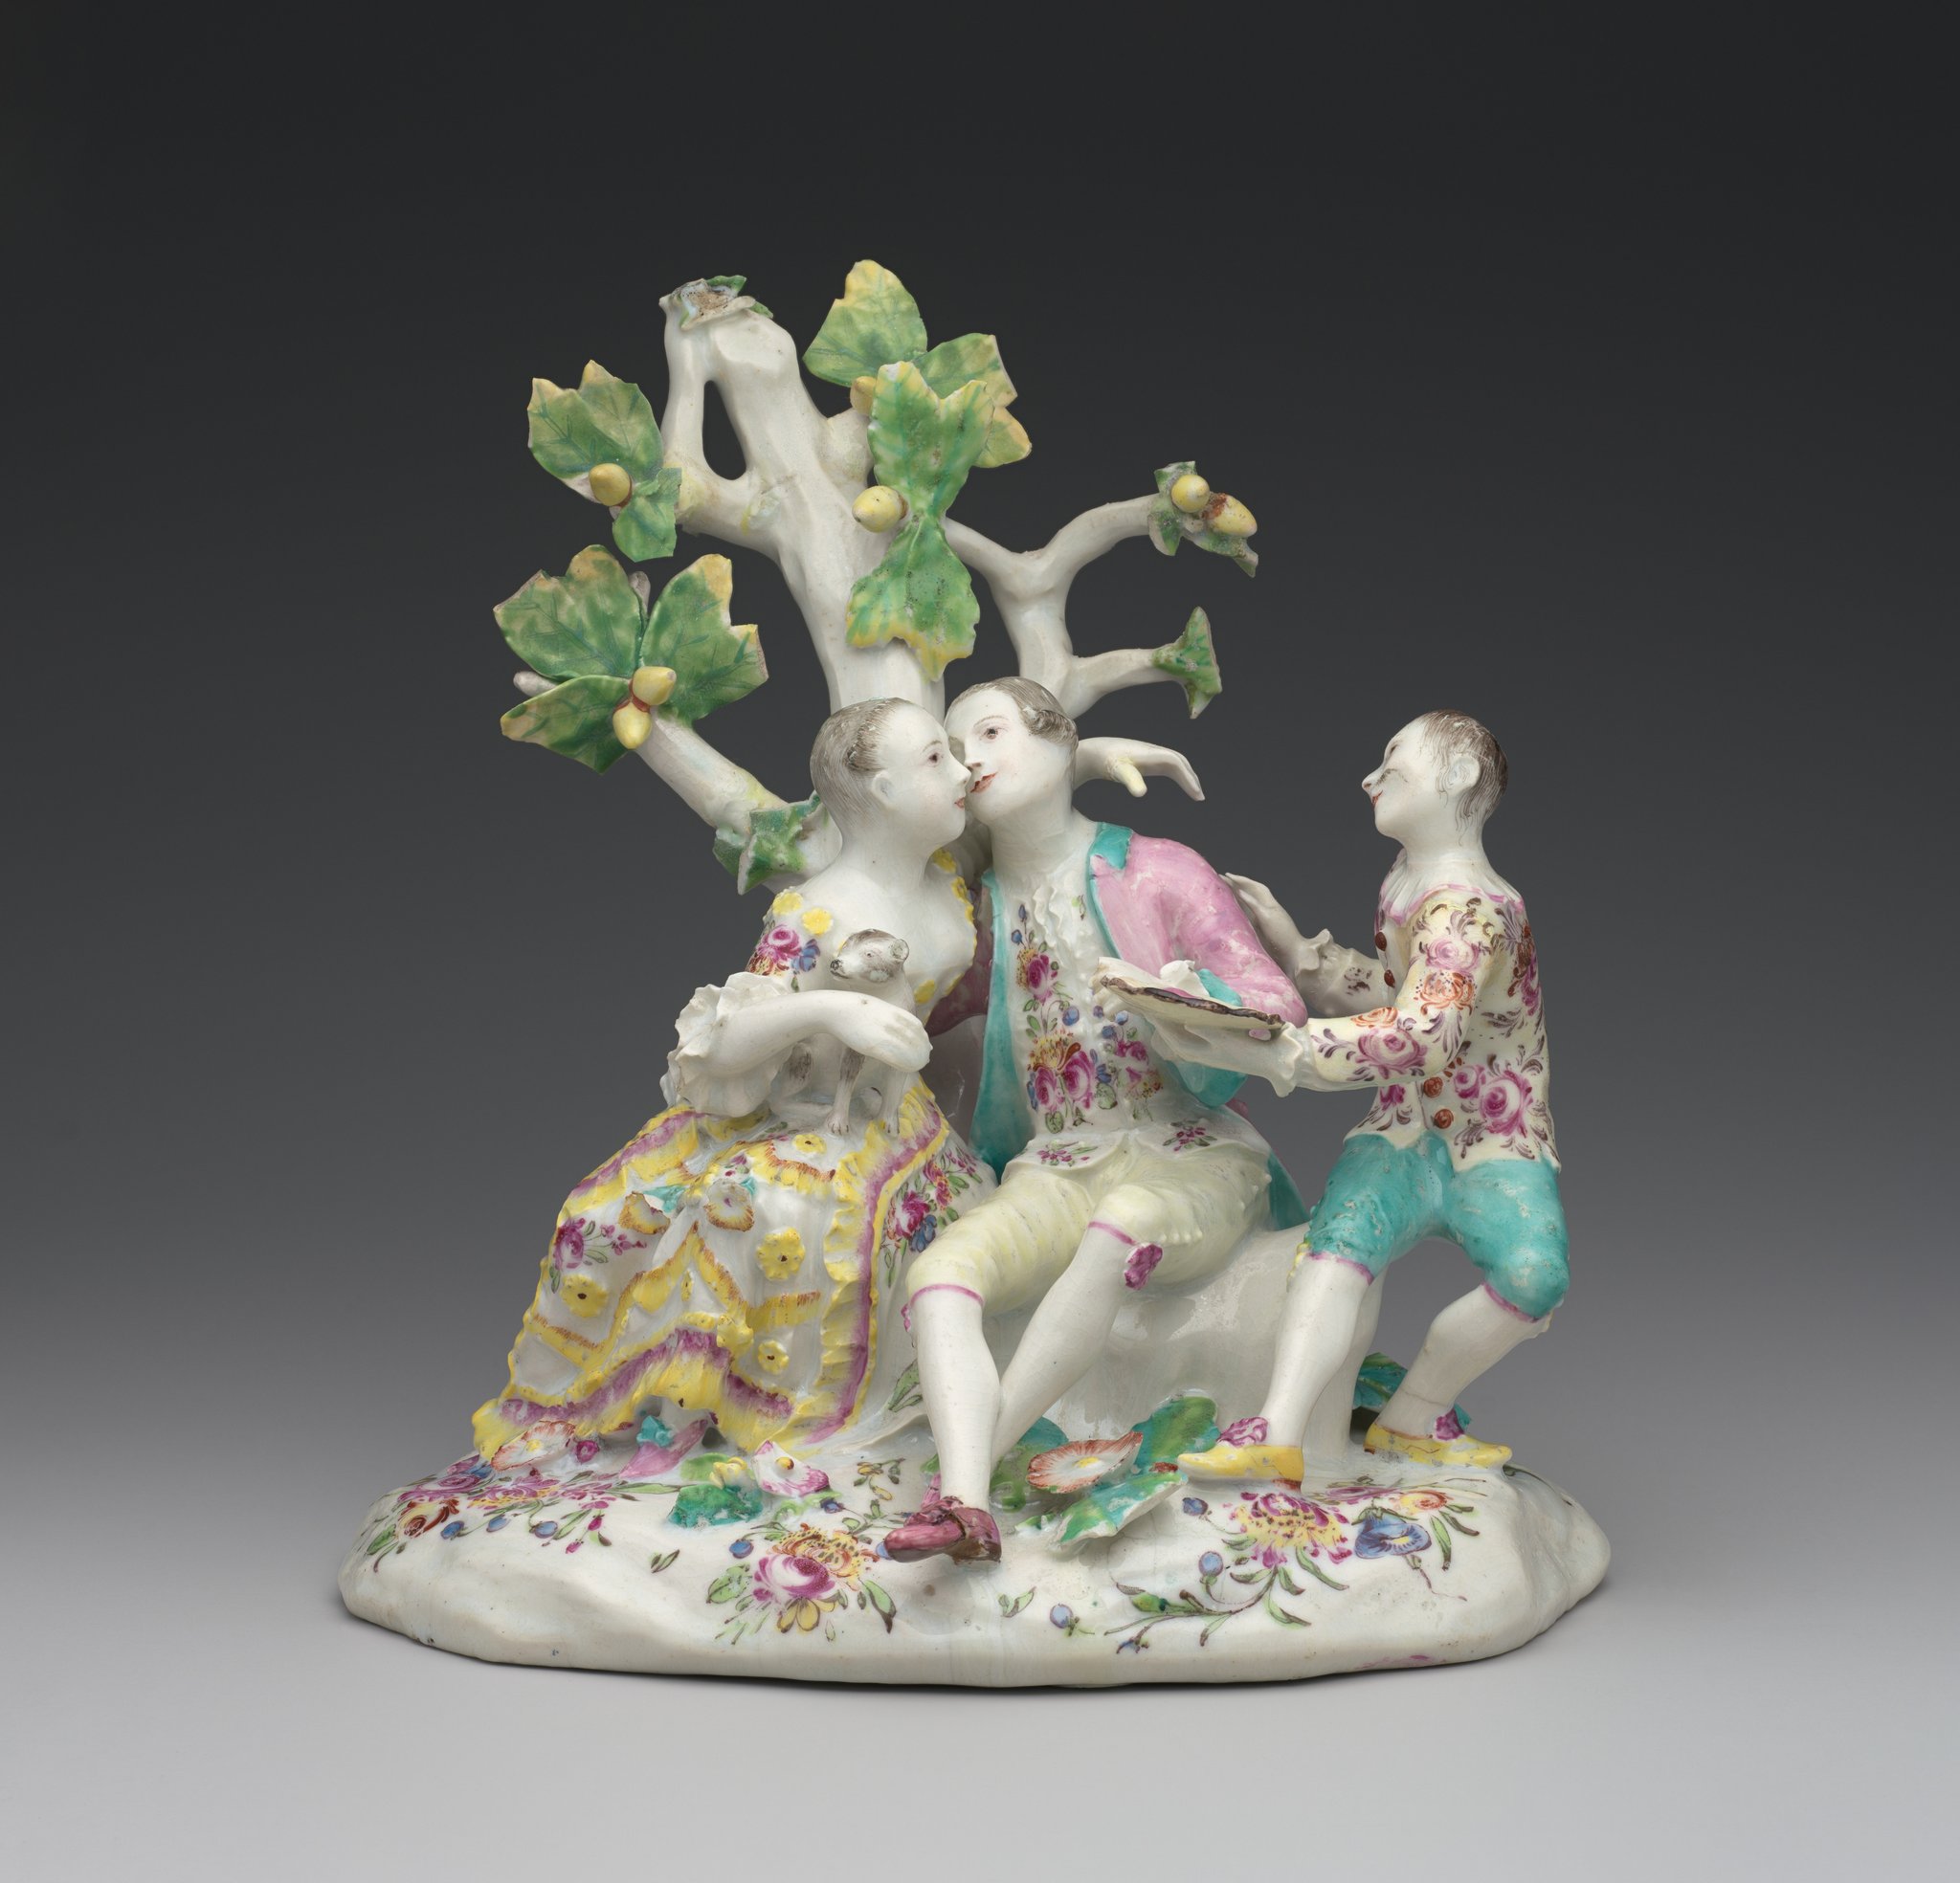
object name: group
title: Lovers and clown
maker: derby porcelain manufactory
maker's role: factory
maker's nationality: british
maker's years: 1751-1785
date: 1755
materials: soft paste porcelain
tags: couples,clowns